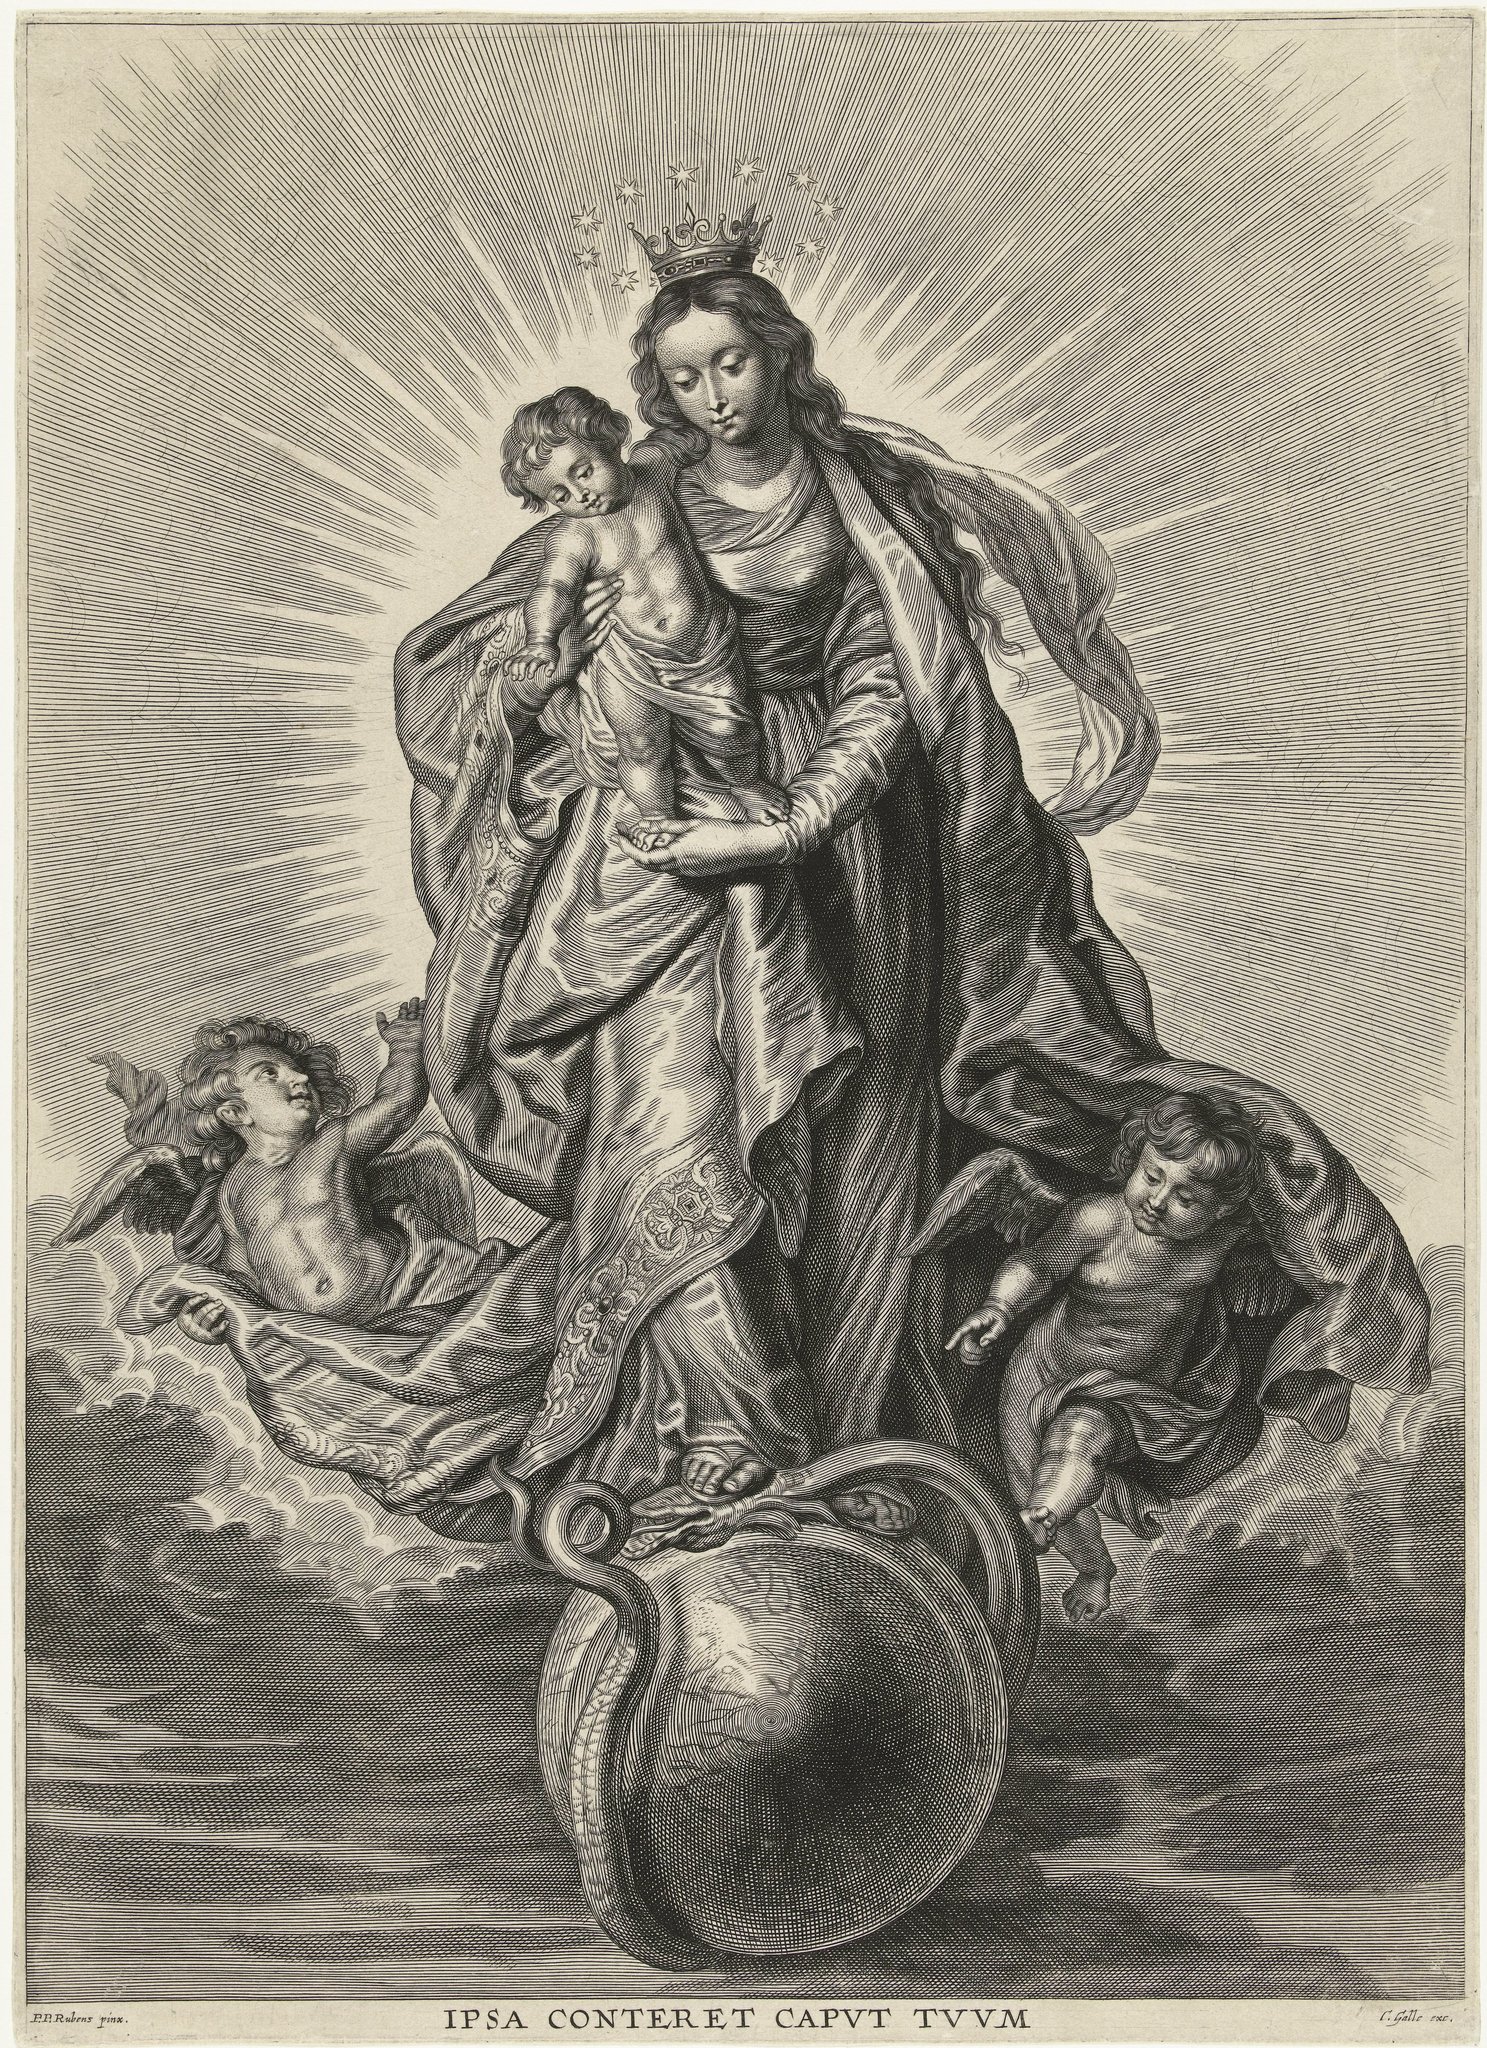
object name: print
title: Maria met kind op wereldbol, de duivel vertrappend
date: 1596-1709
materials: paper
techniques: engraving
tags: madonna (i.e. mary with the christ-child) in the air, or on the clouds, mary conquering the devil, spheres ~ heavens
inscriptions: collector's mark: Lugt 240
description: Maria met kind staat op de wereldbol en vertrapt een slang of duivel. Twee kleine engelen houden de slippen van haar mantel vast. Onder de voorstelling staat een Latijns citaat uit bijbeltekst Genesis 3.